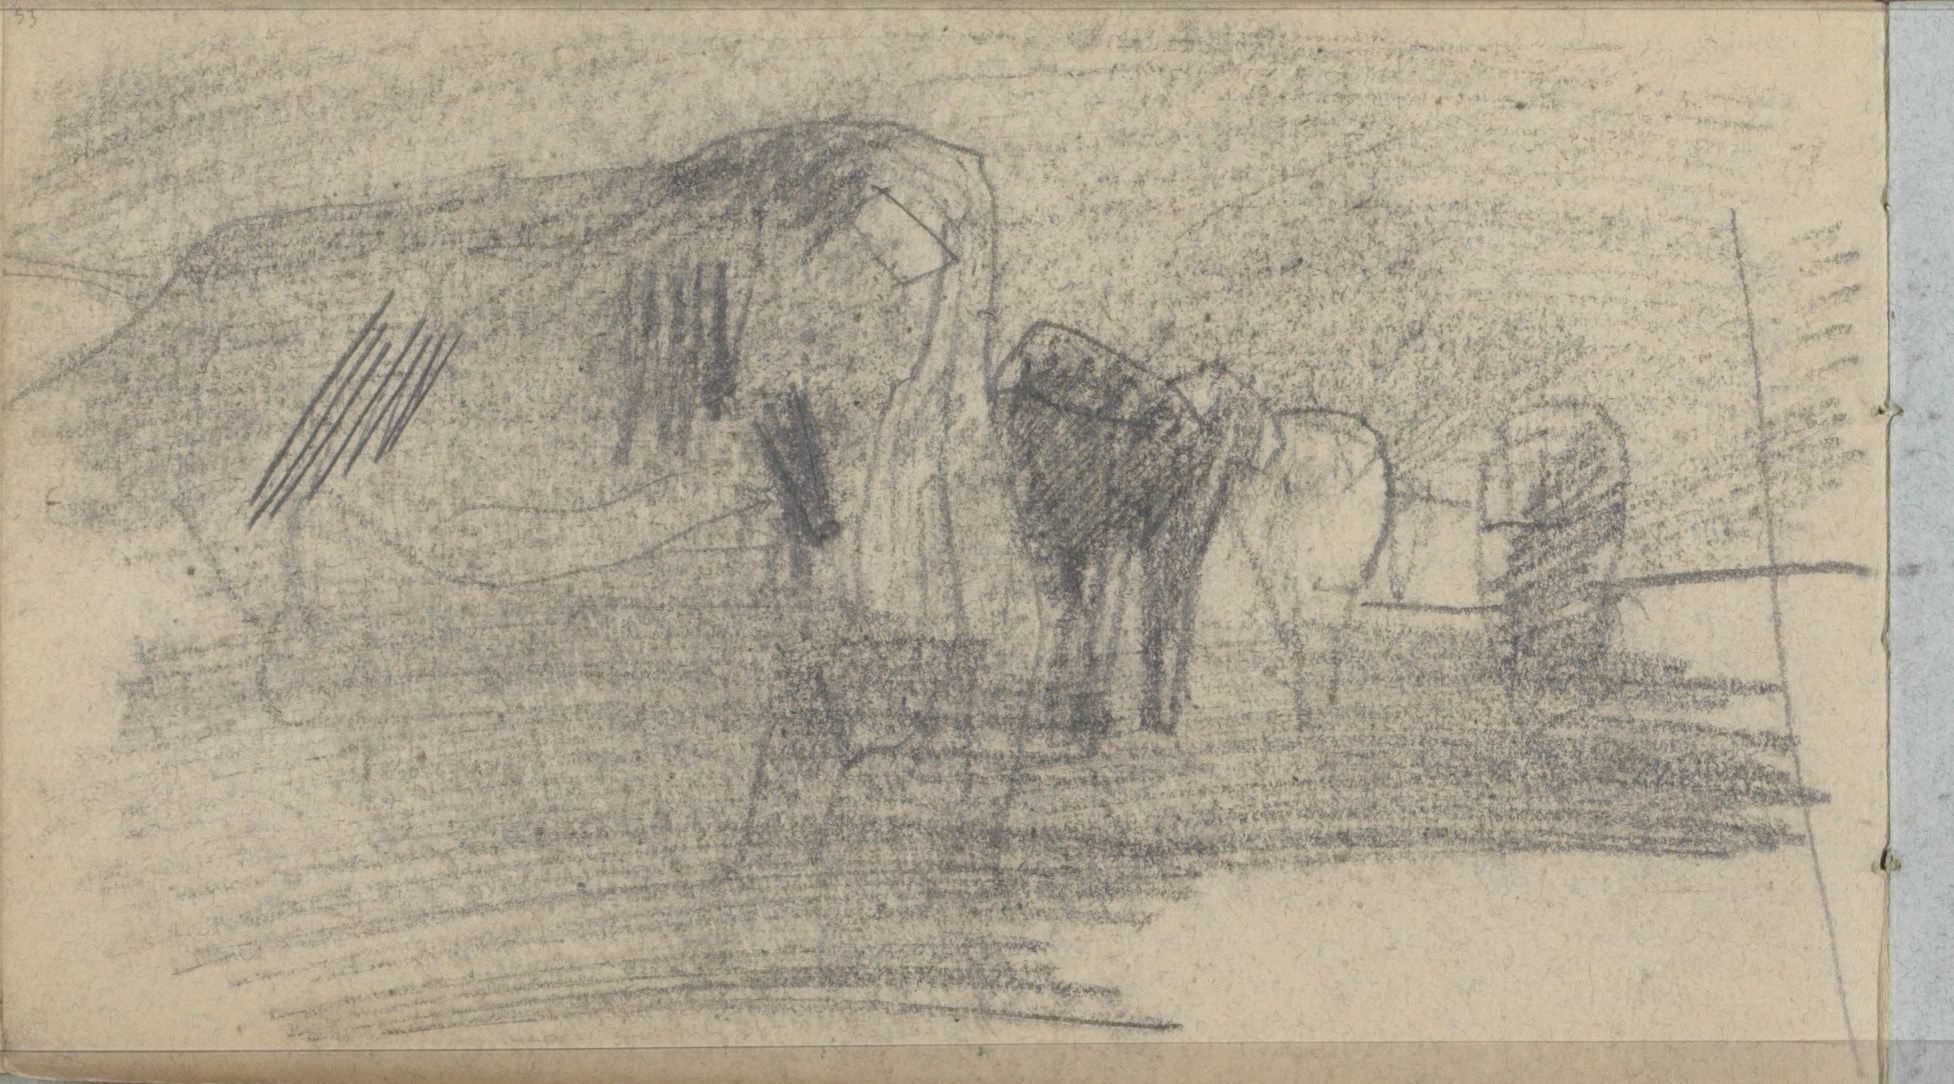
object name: sketchbook leaf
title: Koeien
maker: george hendrik breitner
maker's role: draughtsman, painter, print maker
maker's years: 1857-1923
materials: paper, pencil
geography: amsterdam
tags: cow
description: Pagina 53 uit een schetsboek met 32 bladen.